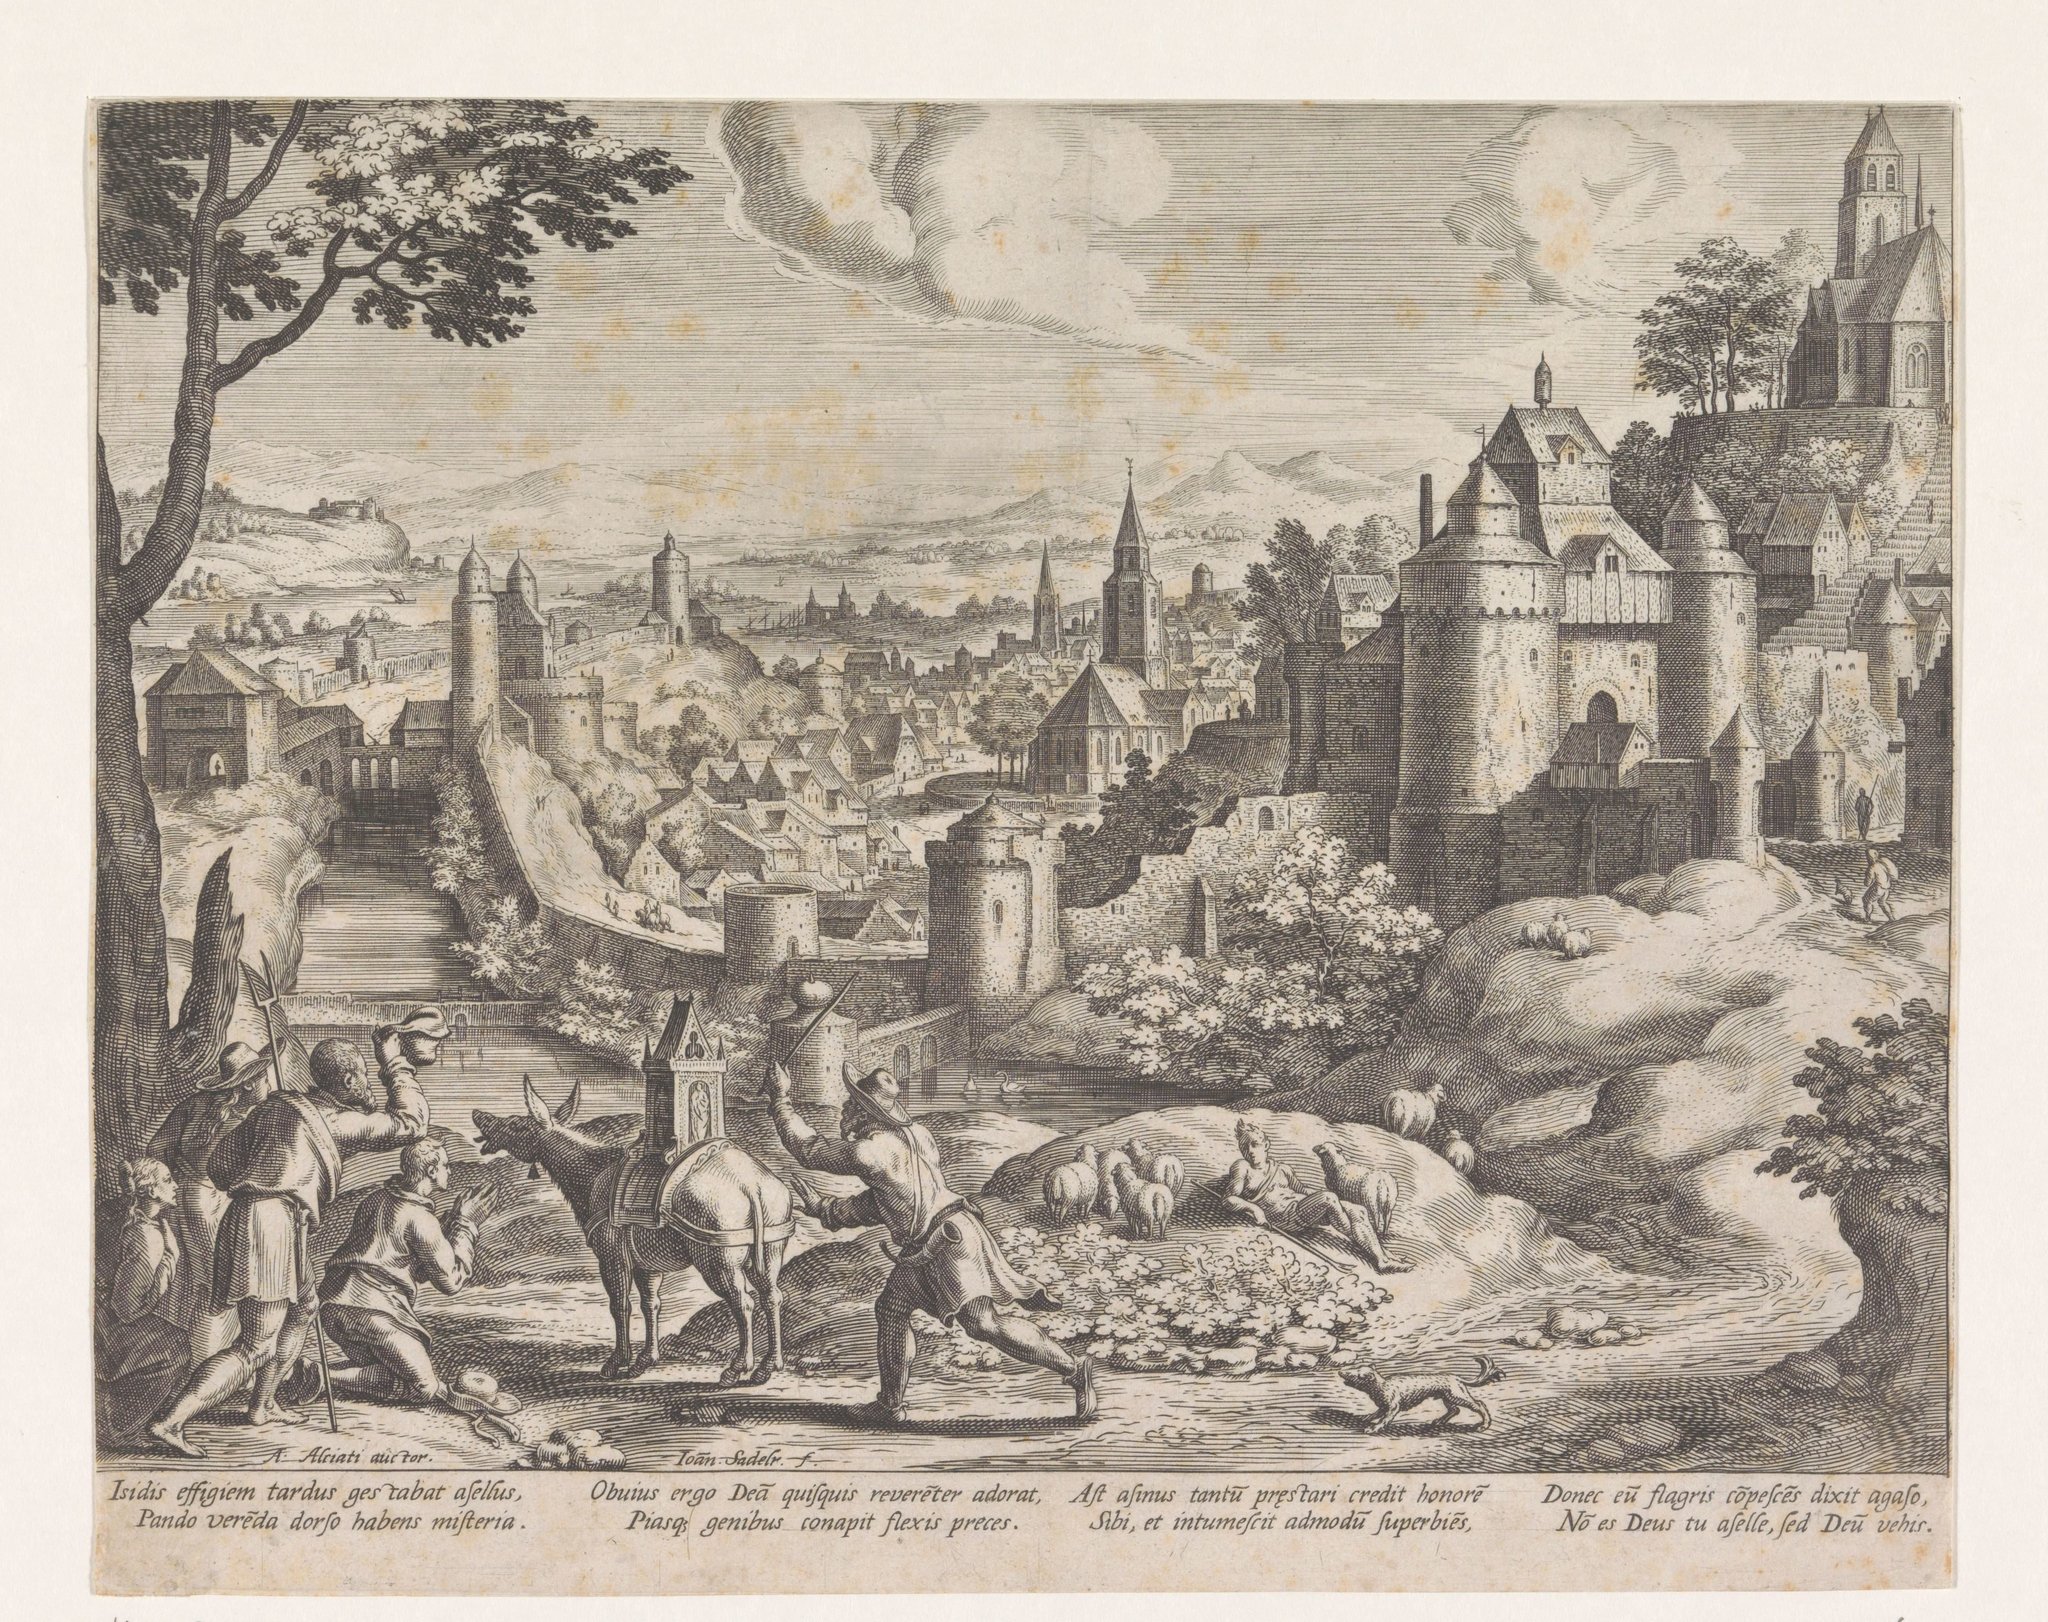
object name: print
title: Emblemen in een landschap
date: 1595-1600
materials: paper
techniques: engraving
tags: ass, donkey, flogging, scourging (in public), arrogance; 'arroganza' (ripa) (+ emblematical representation of concept), isis, whip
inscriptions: collector's mark: ‘Hinloopen’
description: Heuvelachtig landschap met een stad en de stadsmuren. Links op de voorgrond aanbidden enkele boeren een beeld van de godin Isis dat op een ezel wordt vervoerd. Naast de ezel staat een man die met een zweep het dier afstraft. De ezel denkt namelijk dat de mensen hem, in plaats van Isis, aanbidden. Dit is de verbeelding van een embleem waarbij het moraal van het verhaal waarschuwt tegen arrogantie en onverdiende eer. De prent heeft een Latijns onderschrift met het bijschrift van het embleem Non tibi sed religioni van Andrea Alciati.